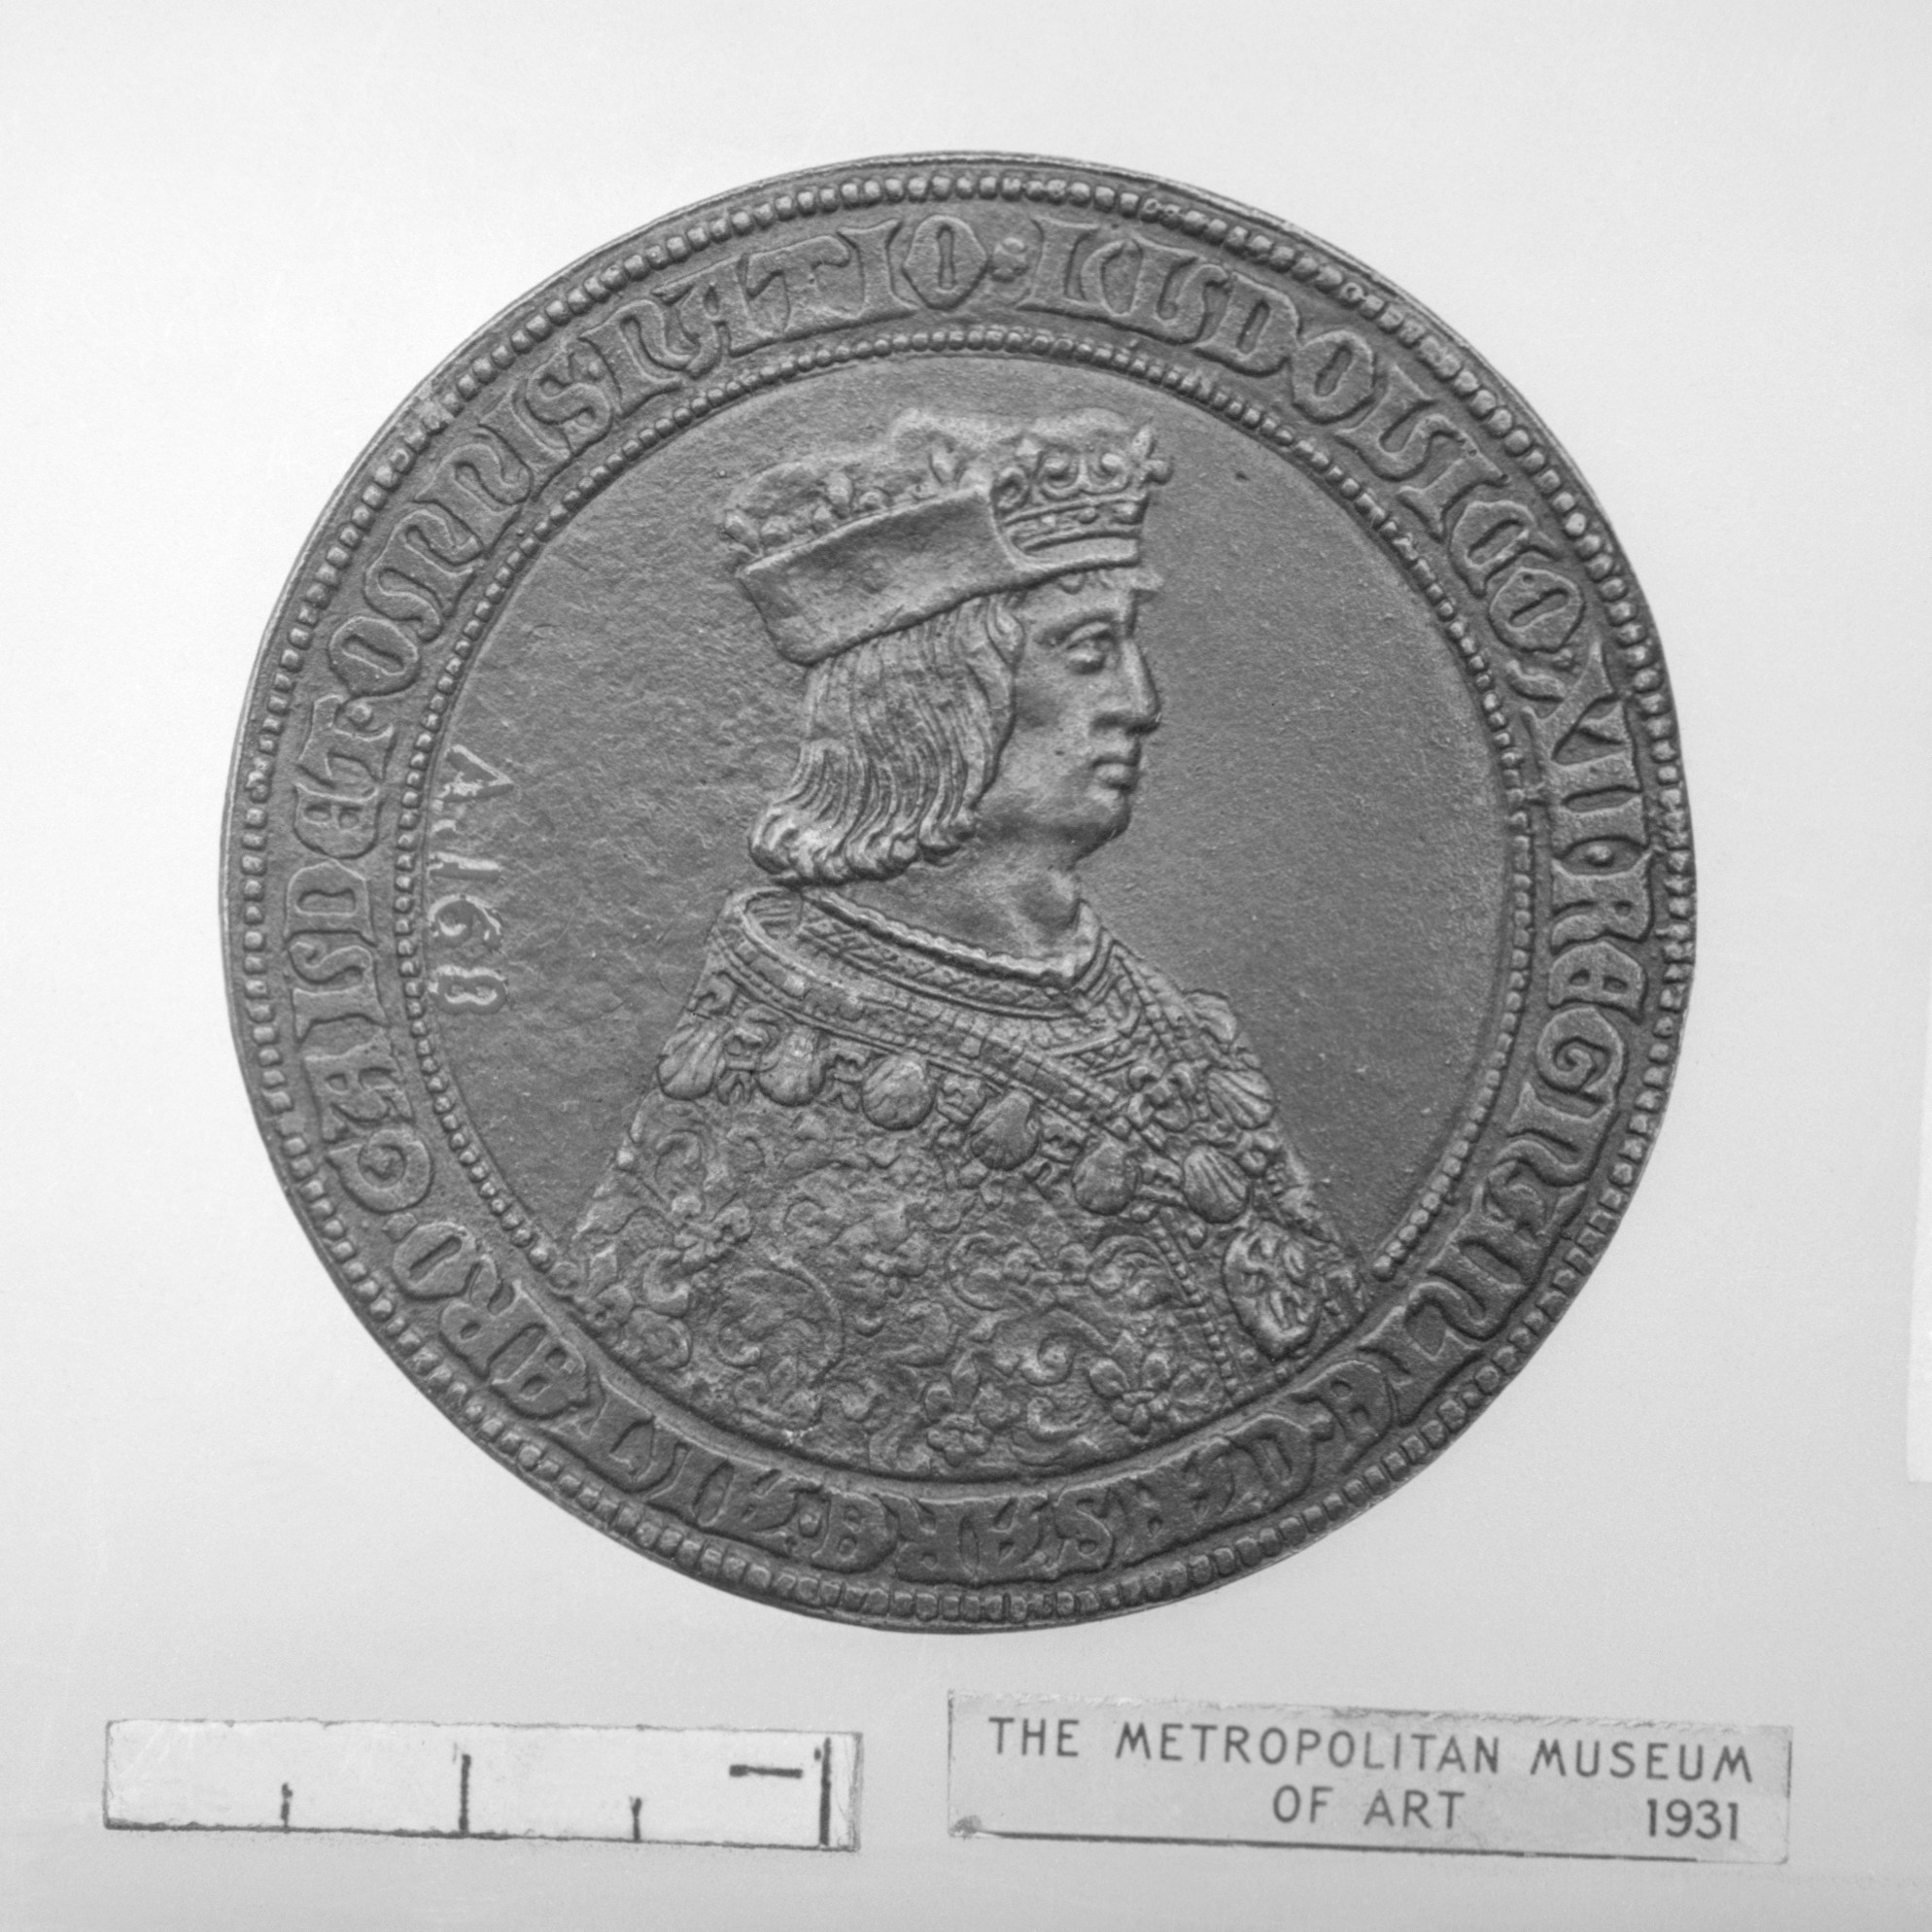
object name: medal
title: Louis XII and Anne of Brittany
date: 1601-1700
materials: bronze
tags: men,profiles,women